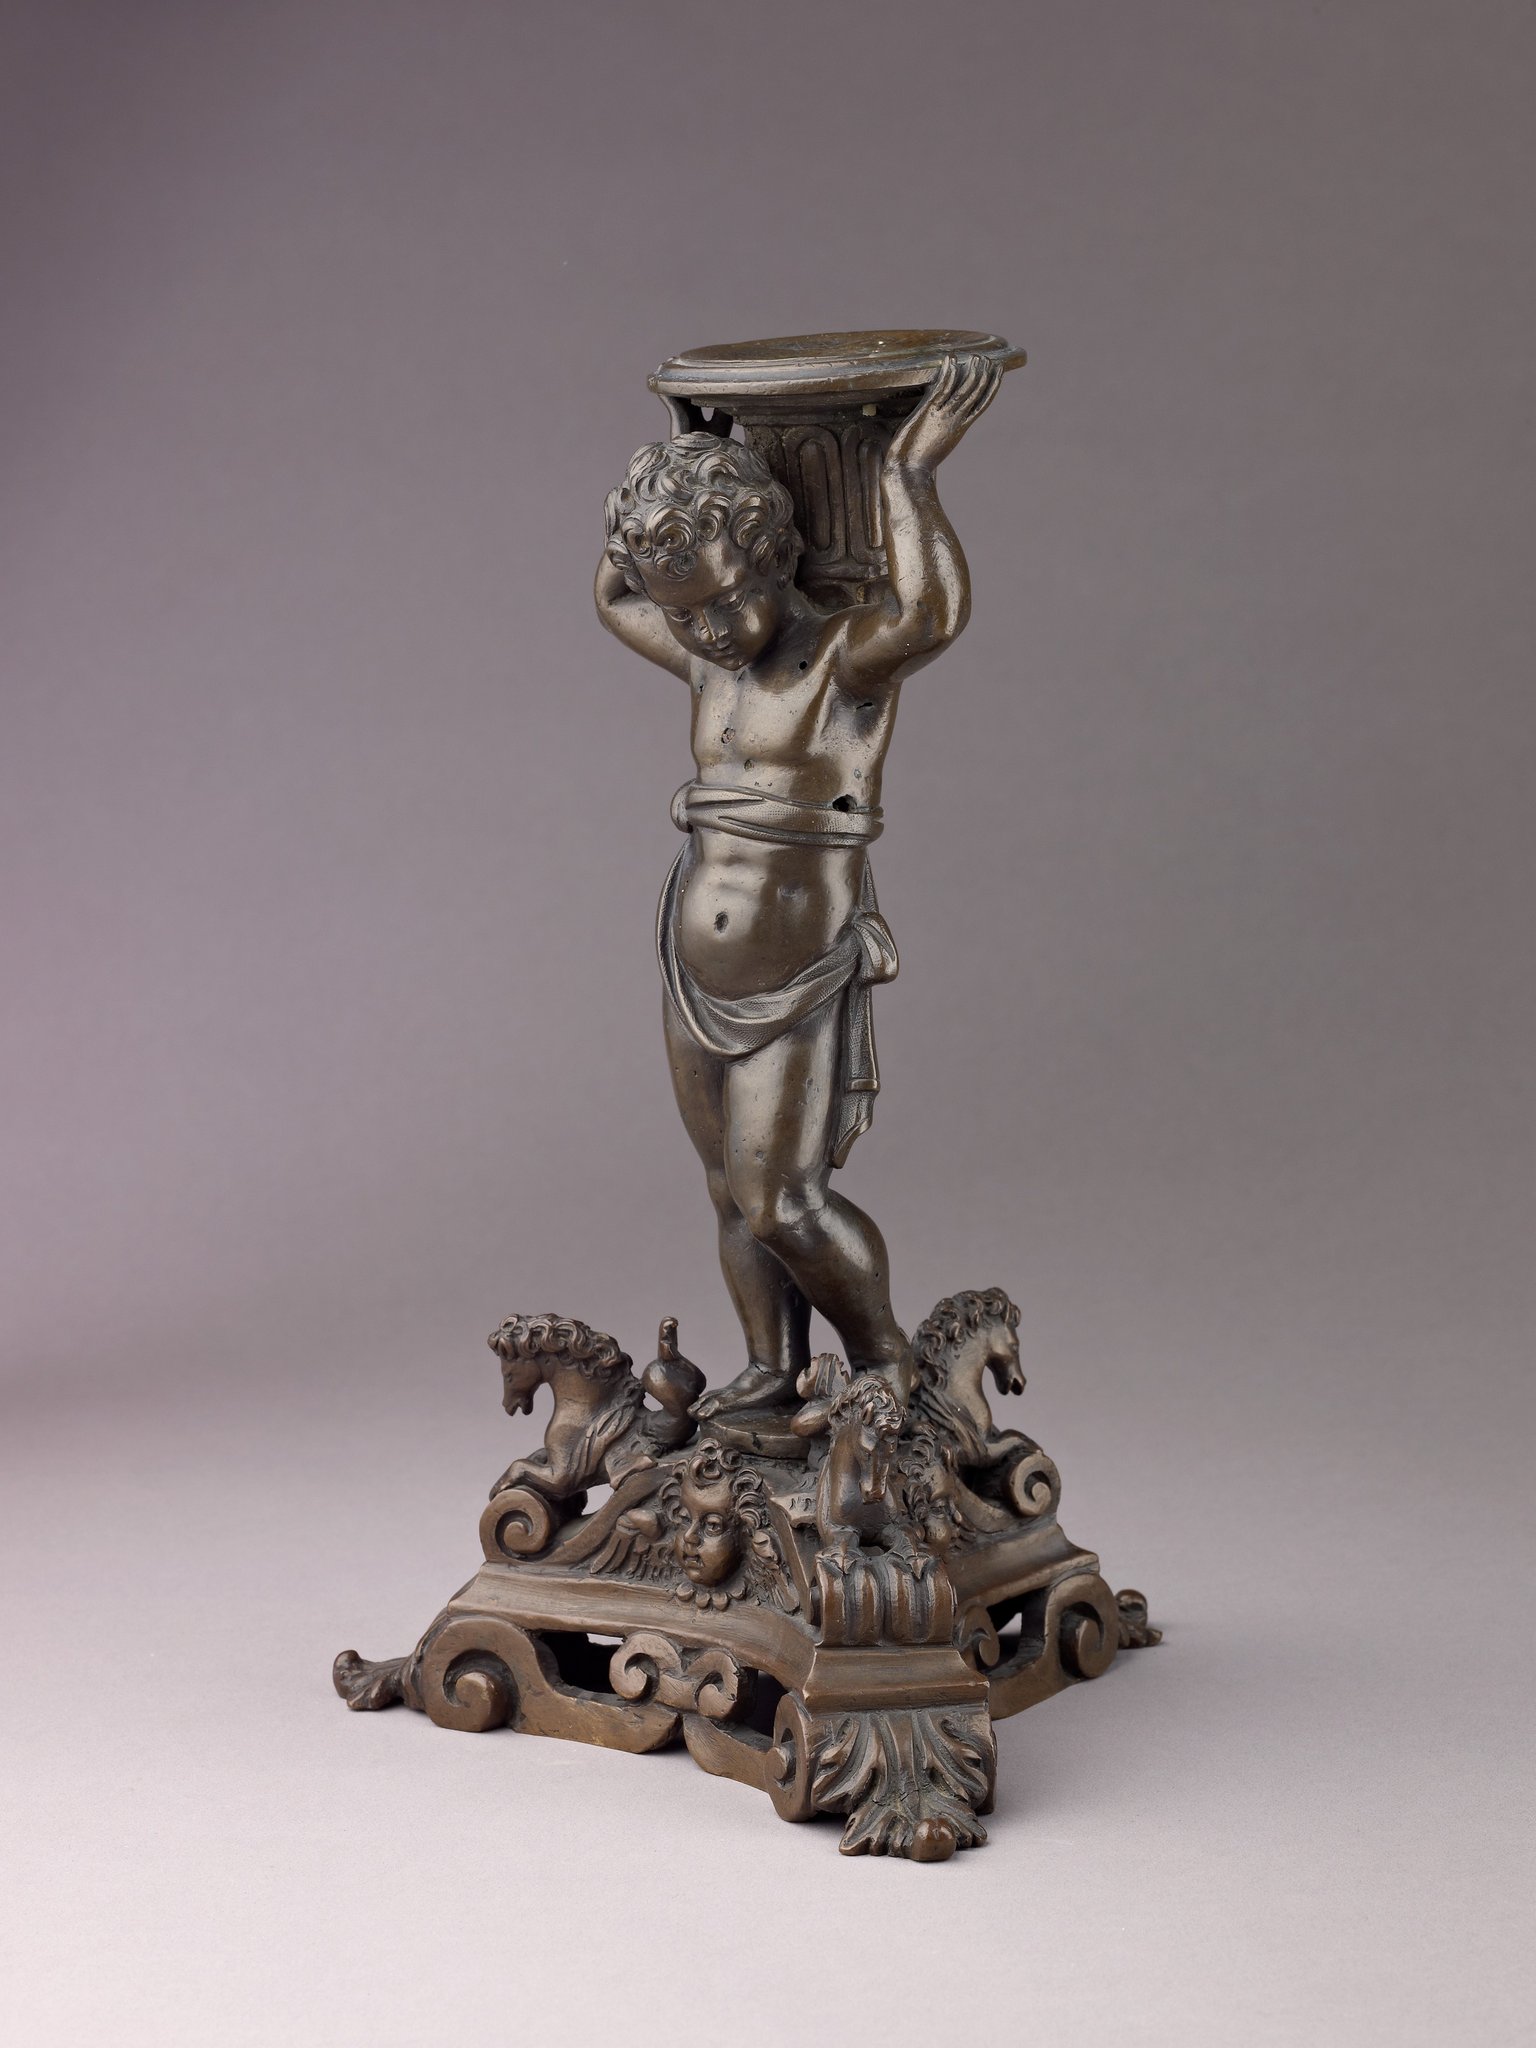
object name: candlestick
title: Candlestick in the form of a Putto (see also 1975.1.1374, .1375, .1377)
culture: italian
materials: bronze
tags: putti,horses